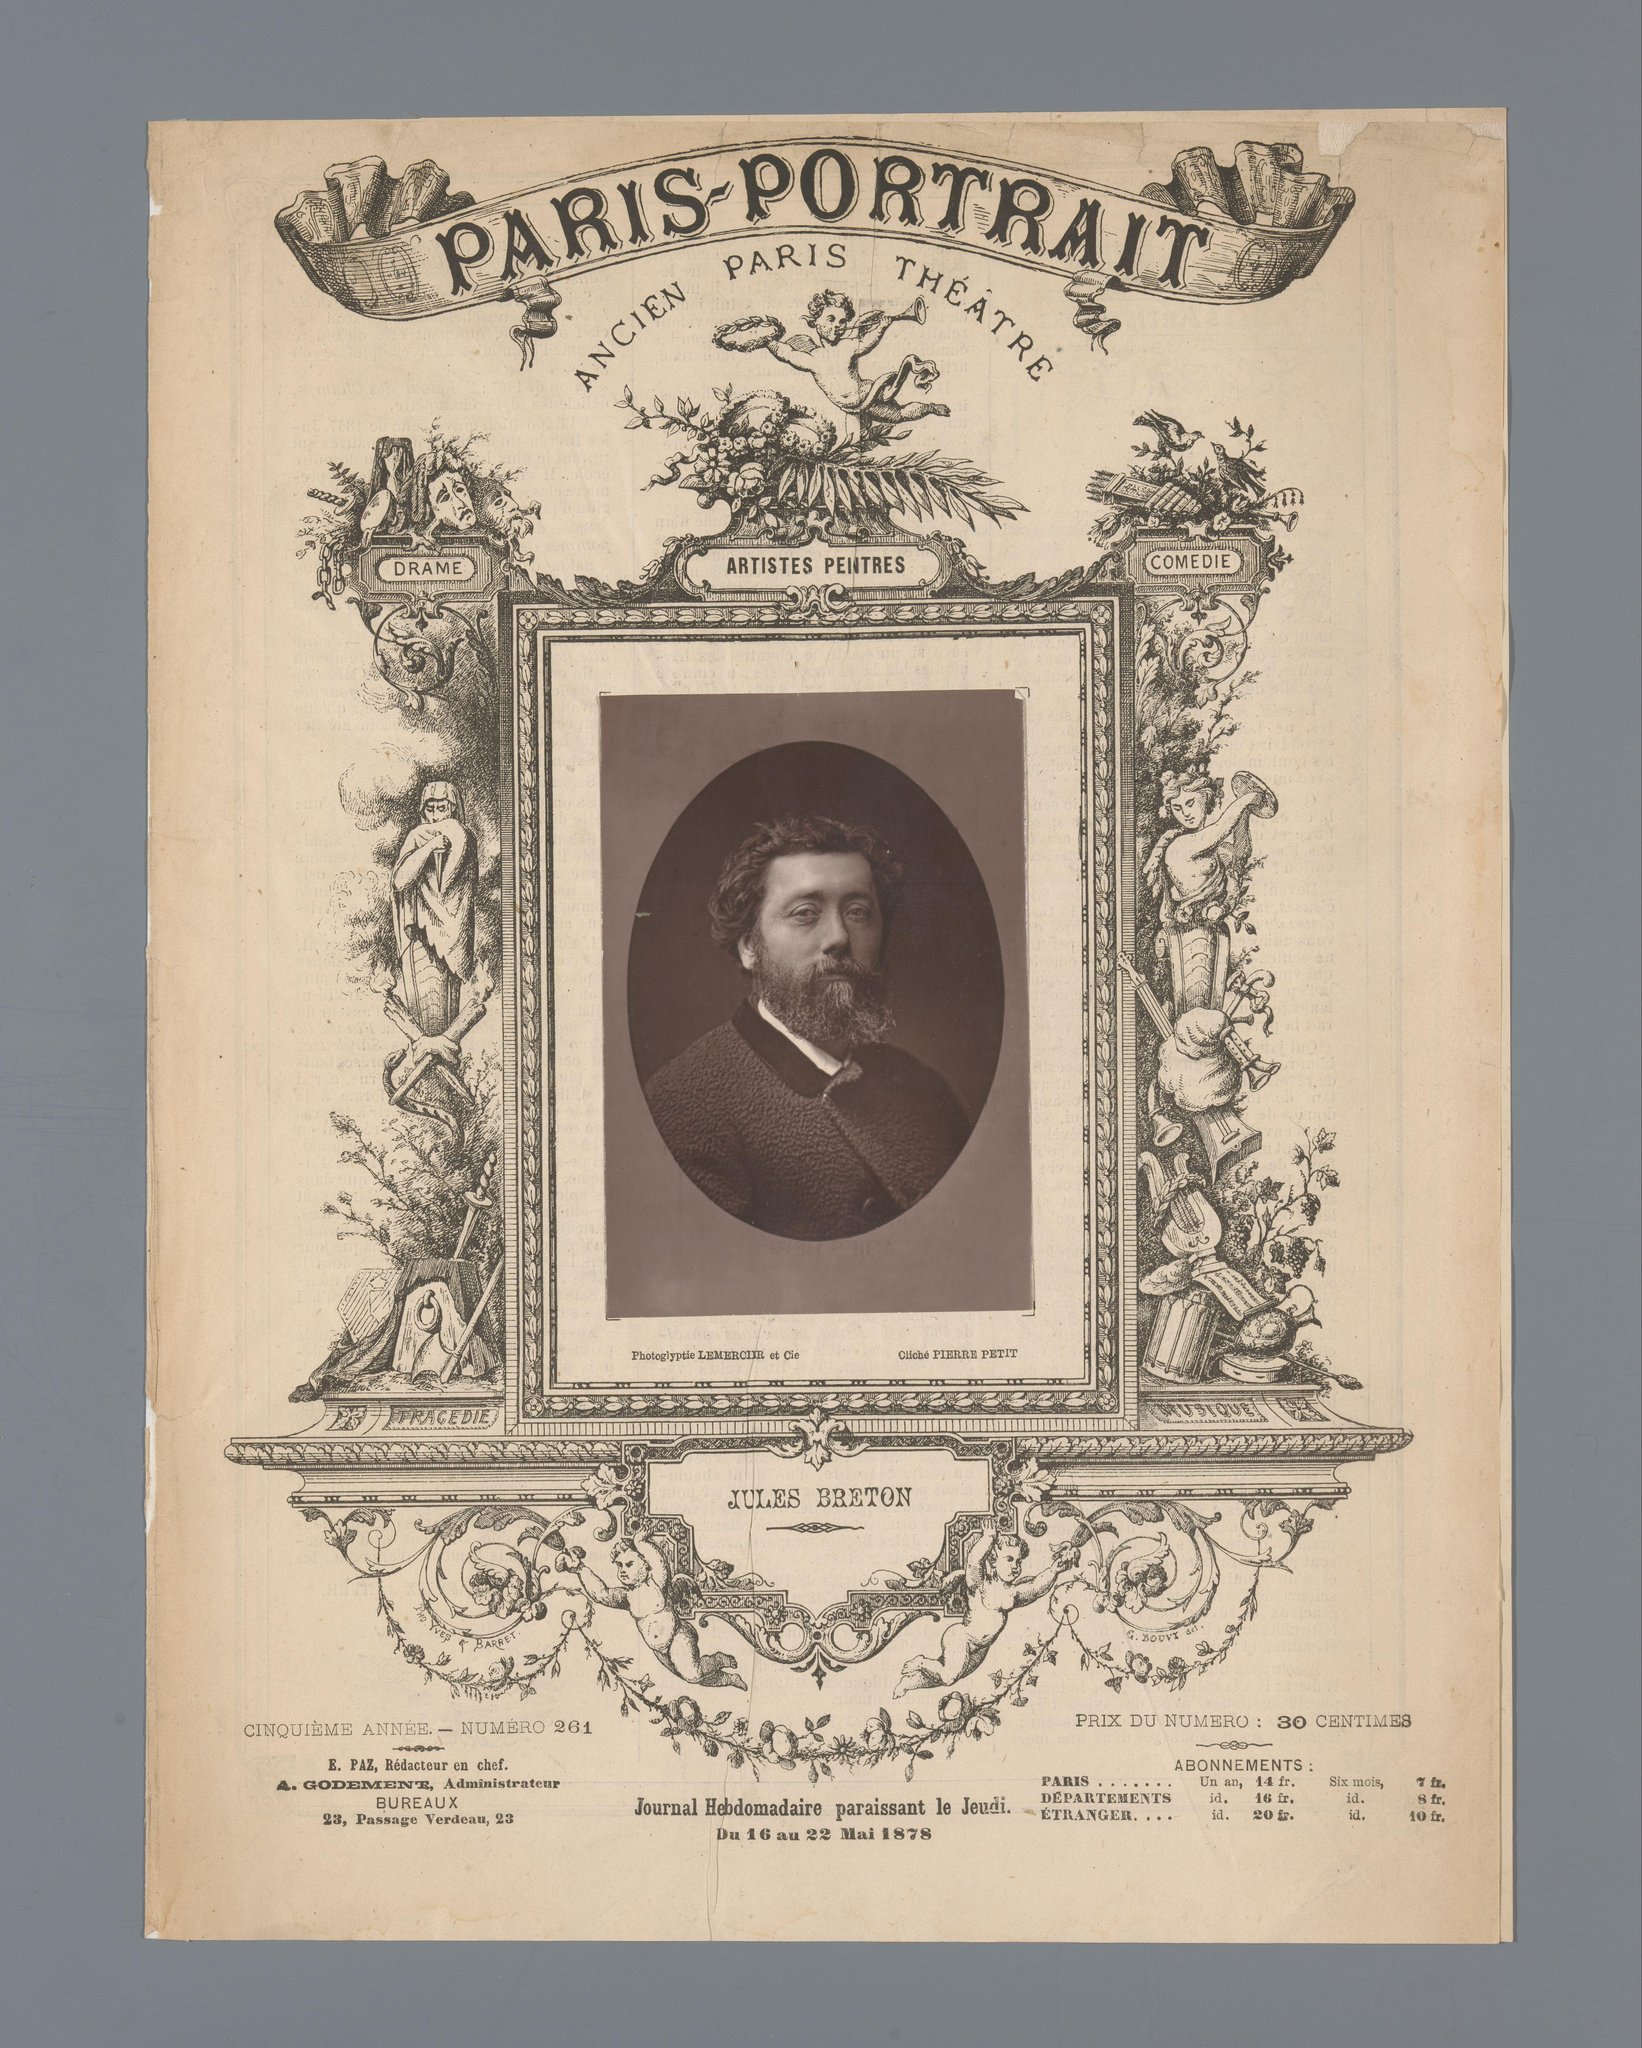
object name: photomechanical print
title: Portret van Jules Breton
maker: pierre petit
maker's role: fotograaf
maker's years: 1832-1909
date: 1873-1880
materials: paper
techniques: woodburytype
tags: painter, jules breton, historical persons